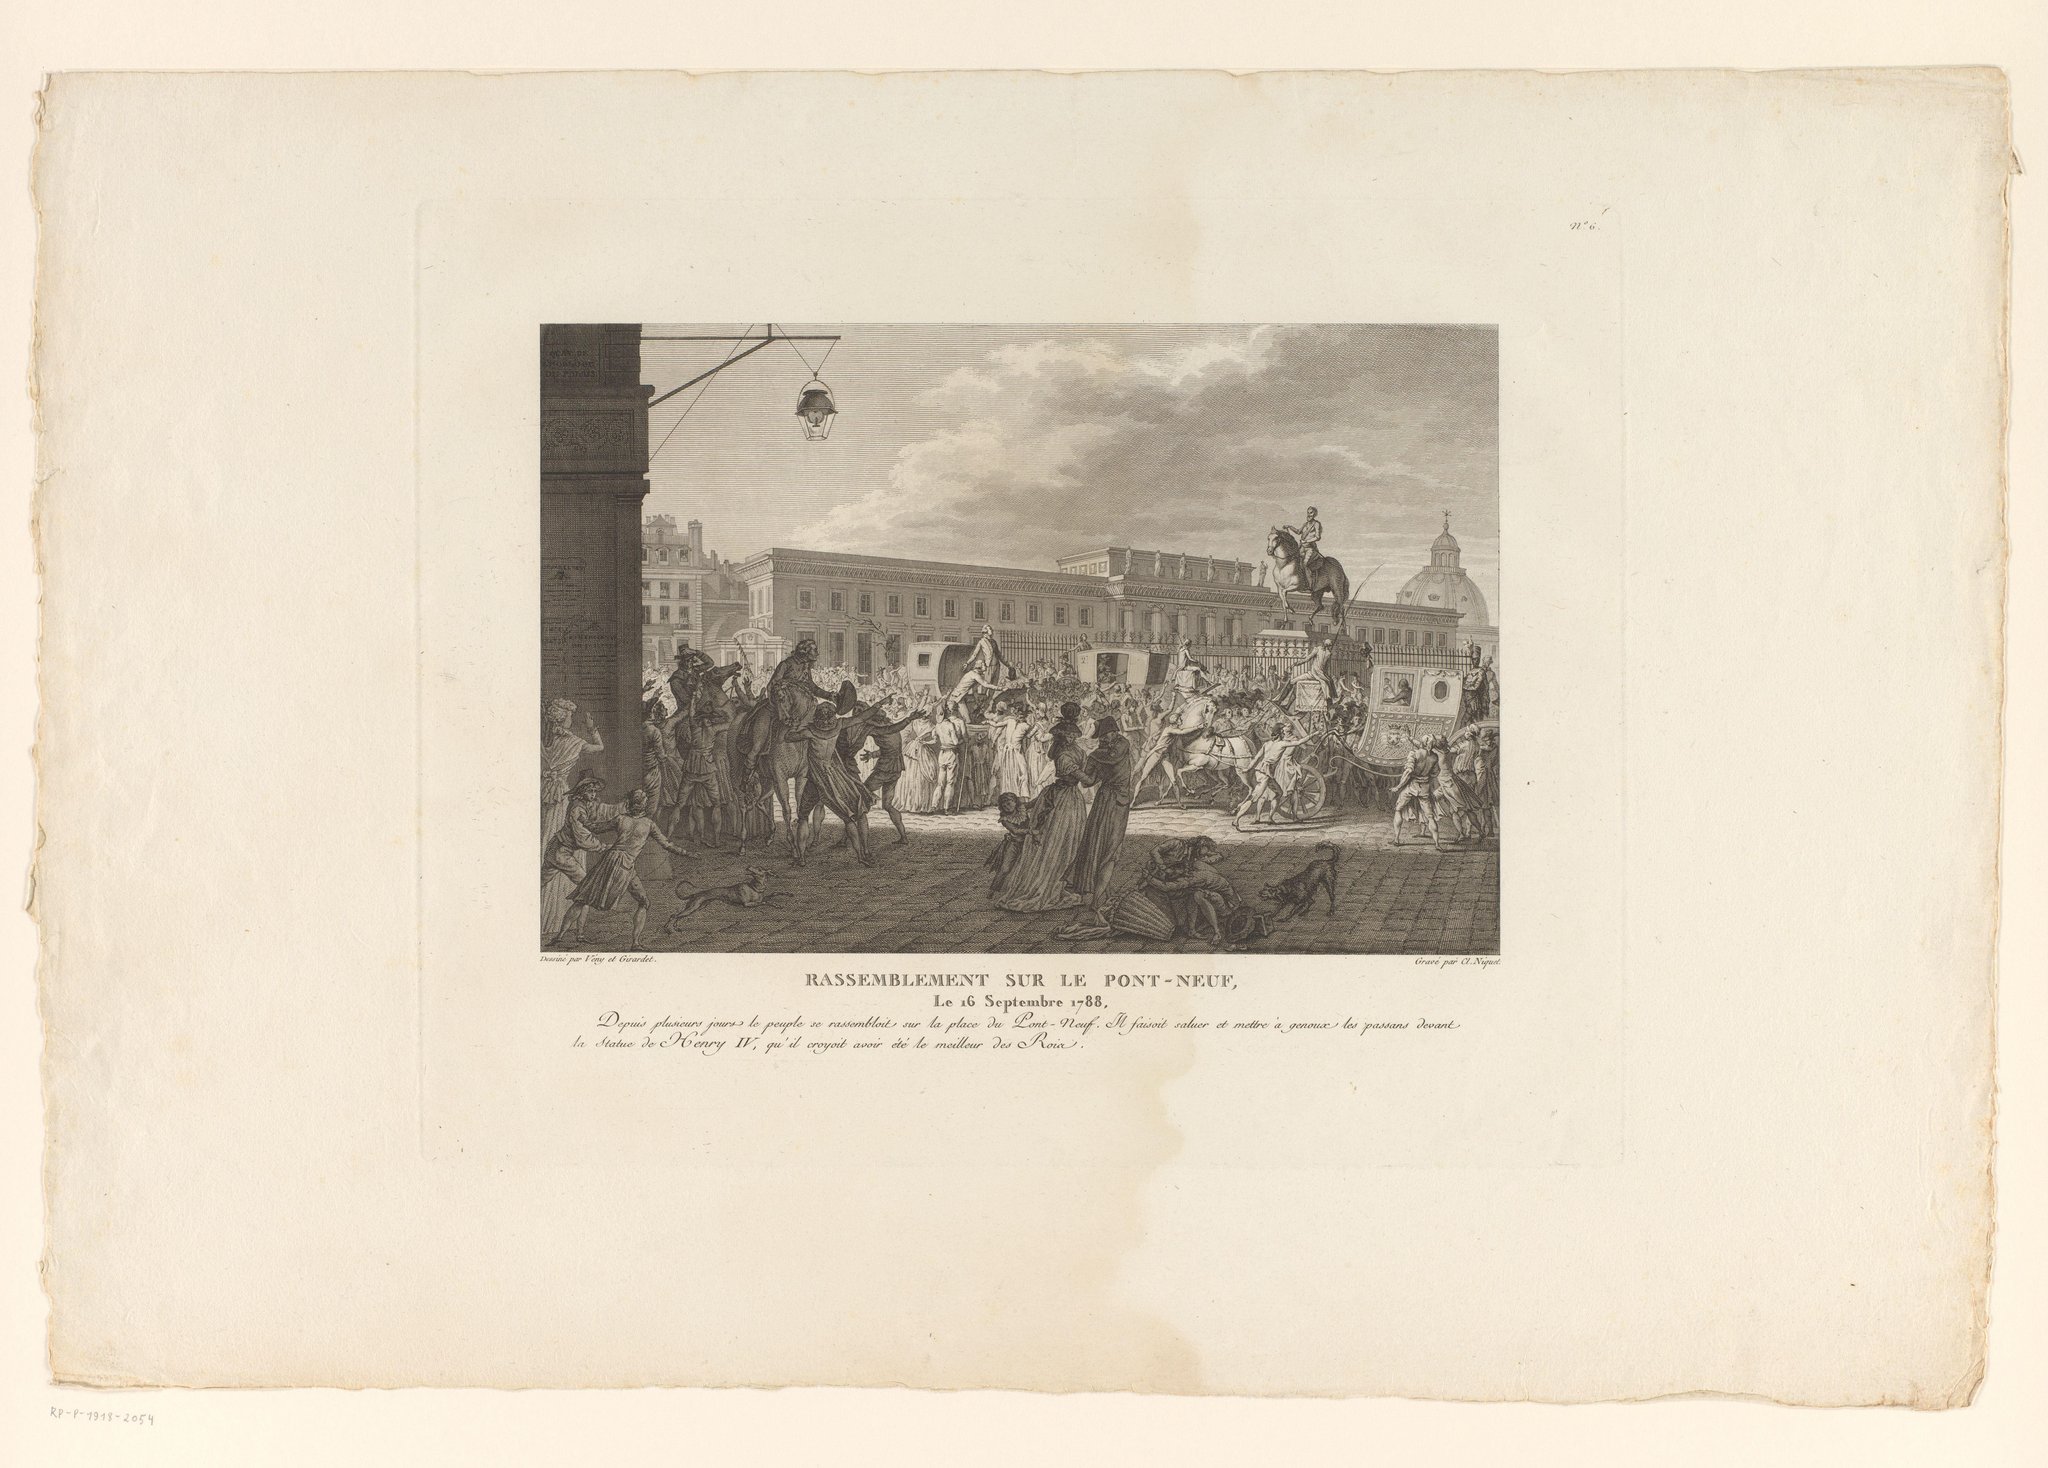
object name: print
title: Prenten naar historische schilderijen over de Franse Revolutie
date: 1791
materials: paper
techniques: engraving, etching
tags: bridge, meeting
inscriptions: collector's mark: Lugt 2233